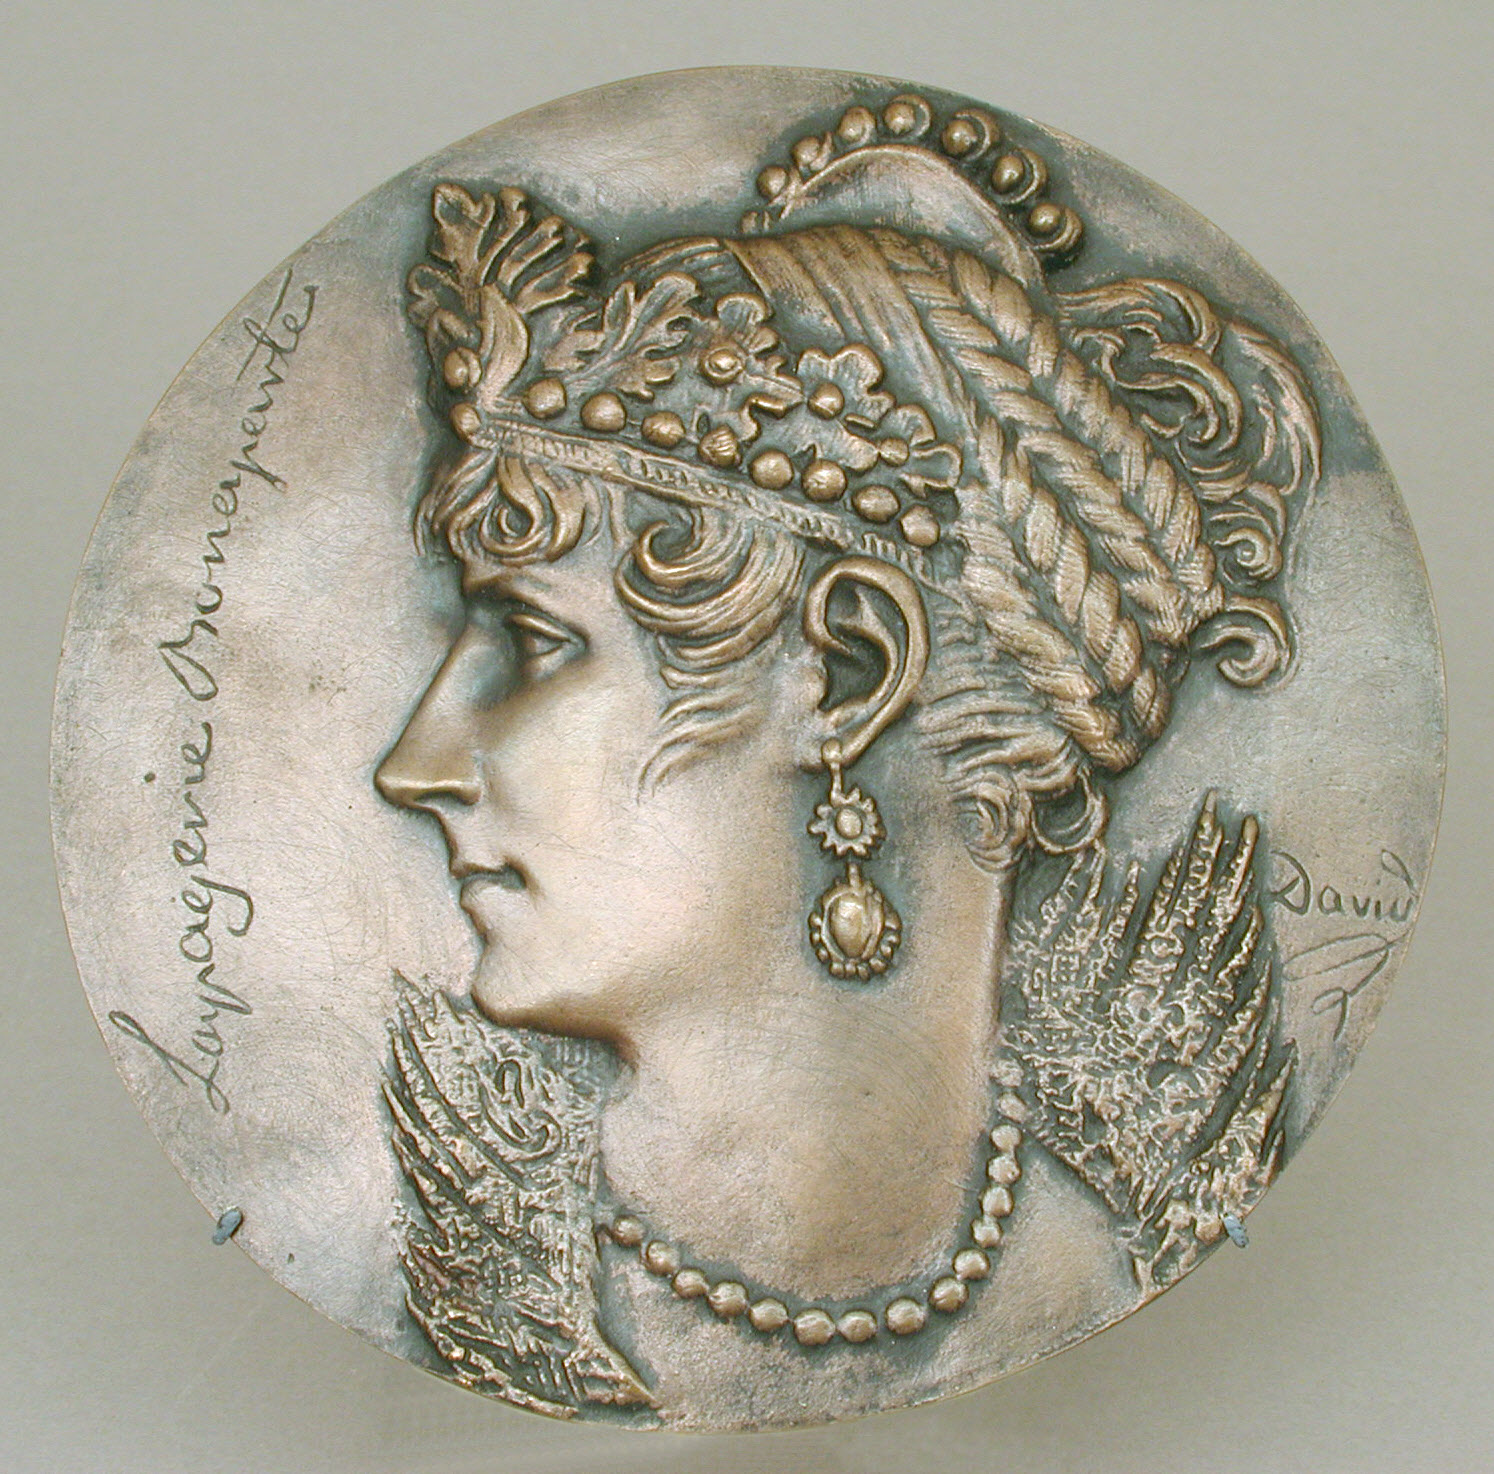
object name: medallion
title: Josephine Bonaparte (née Tascher de la Pagerie), first wife of Napoleon I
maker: pierre jean david d'angers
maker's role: artist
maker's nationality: french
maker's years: 1788-1856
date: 1801-1900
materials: bronze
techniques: casting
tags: historical figures,profiles,women